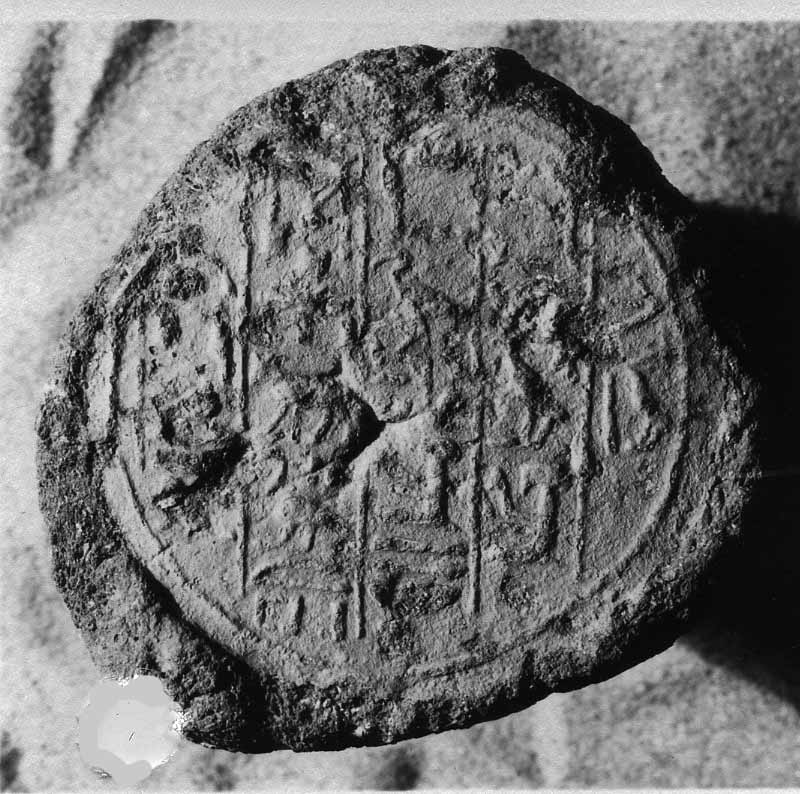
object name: cone, djehutynefer, seshu, scribe, cattle, fowl, amun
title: Funerary Cone of Djehutynefer called Seshu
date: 1550-1295 BCE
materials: pottery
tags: hieroglyphs